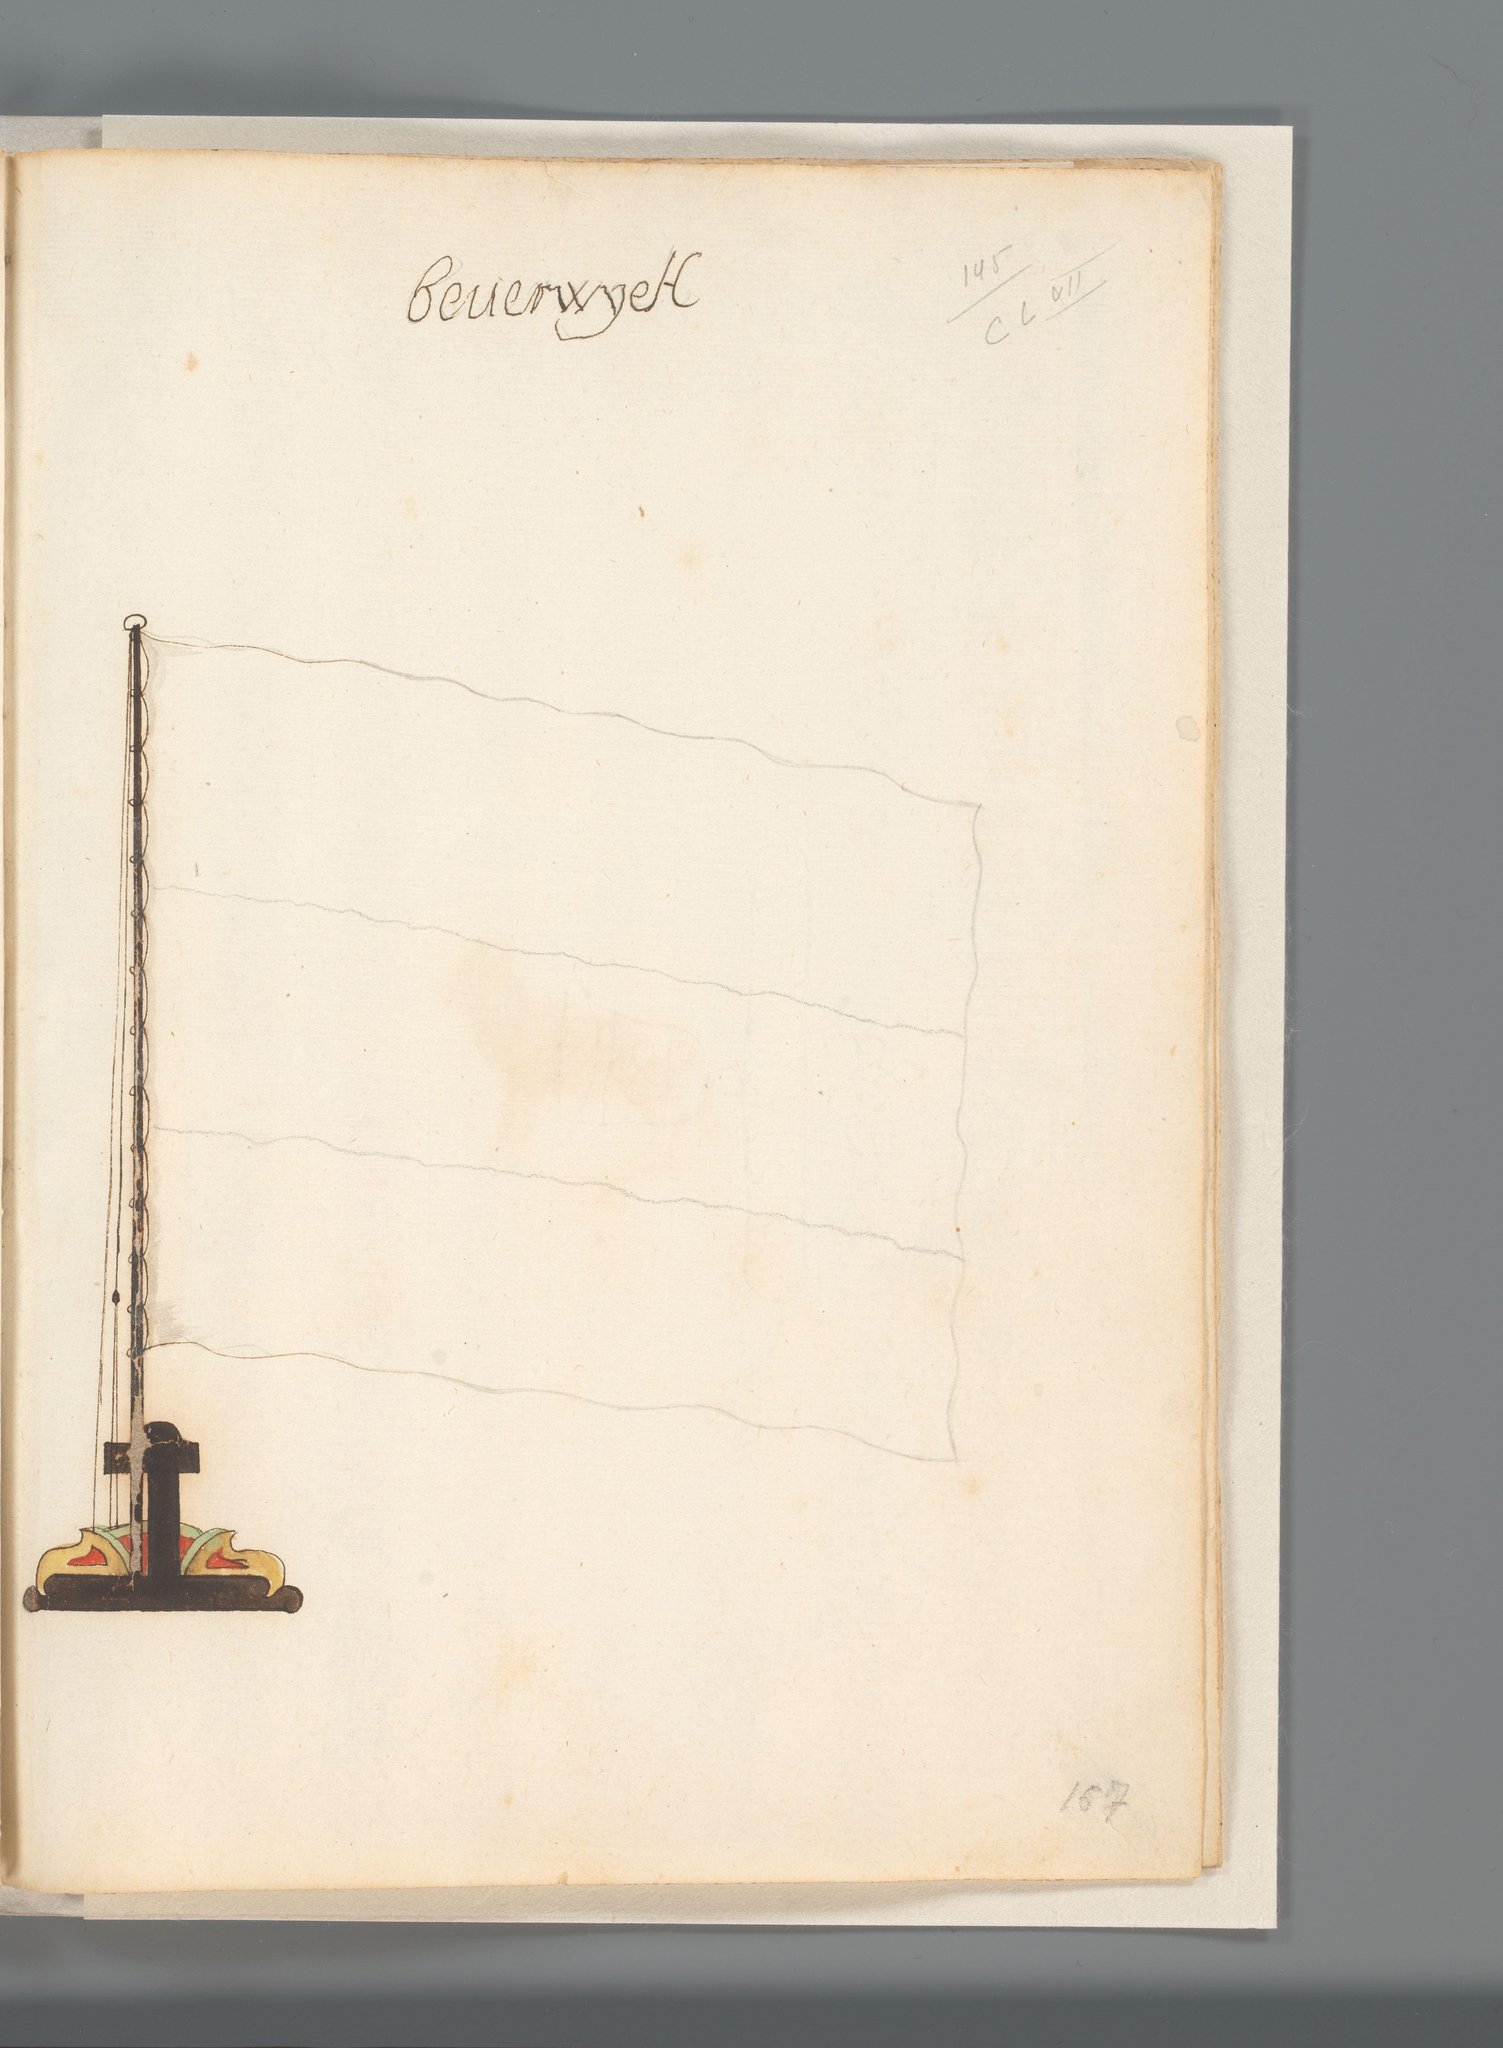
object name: drawing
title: Vlag van Beverwijk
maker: Anonymous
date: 1667-1670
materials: ink, paper, watercolor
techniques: brush, pen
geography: france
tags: flag, colours (as symbol of the state, etc.)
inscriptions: number: ‘145 / CLVII / 157’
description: Blanco, oningevulde vlag, bestemd voor de vlag van de stad Beverwijk. Vlag op vlaggensteng en mastvoet. Afgebeeld op folio 79r. Onderdeel van een vlaggenboek met vlaggen uit Europa, Noord-Afrika, Nabije en Verre Oosten.